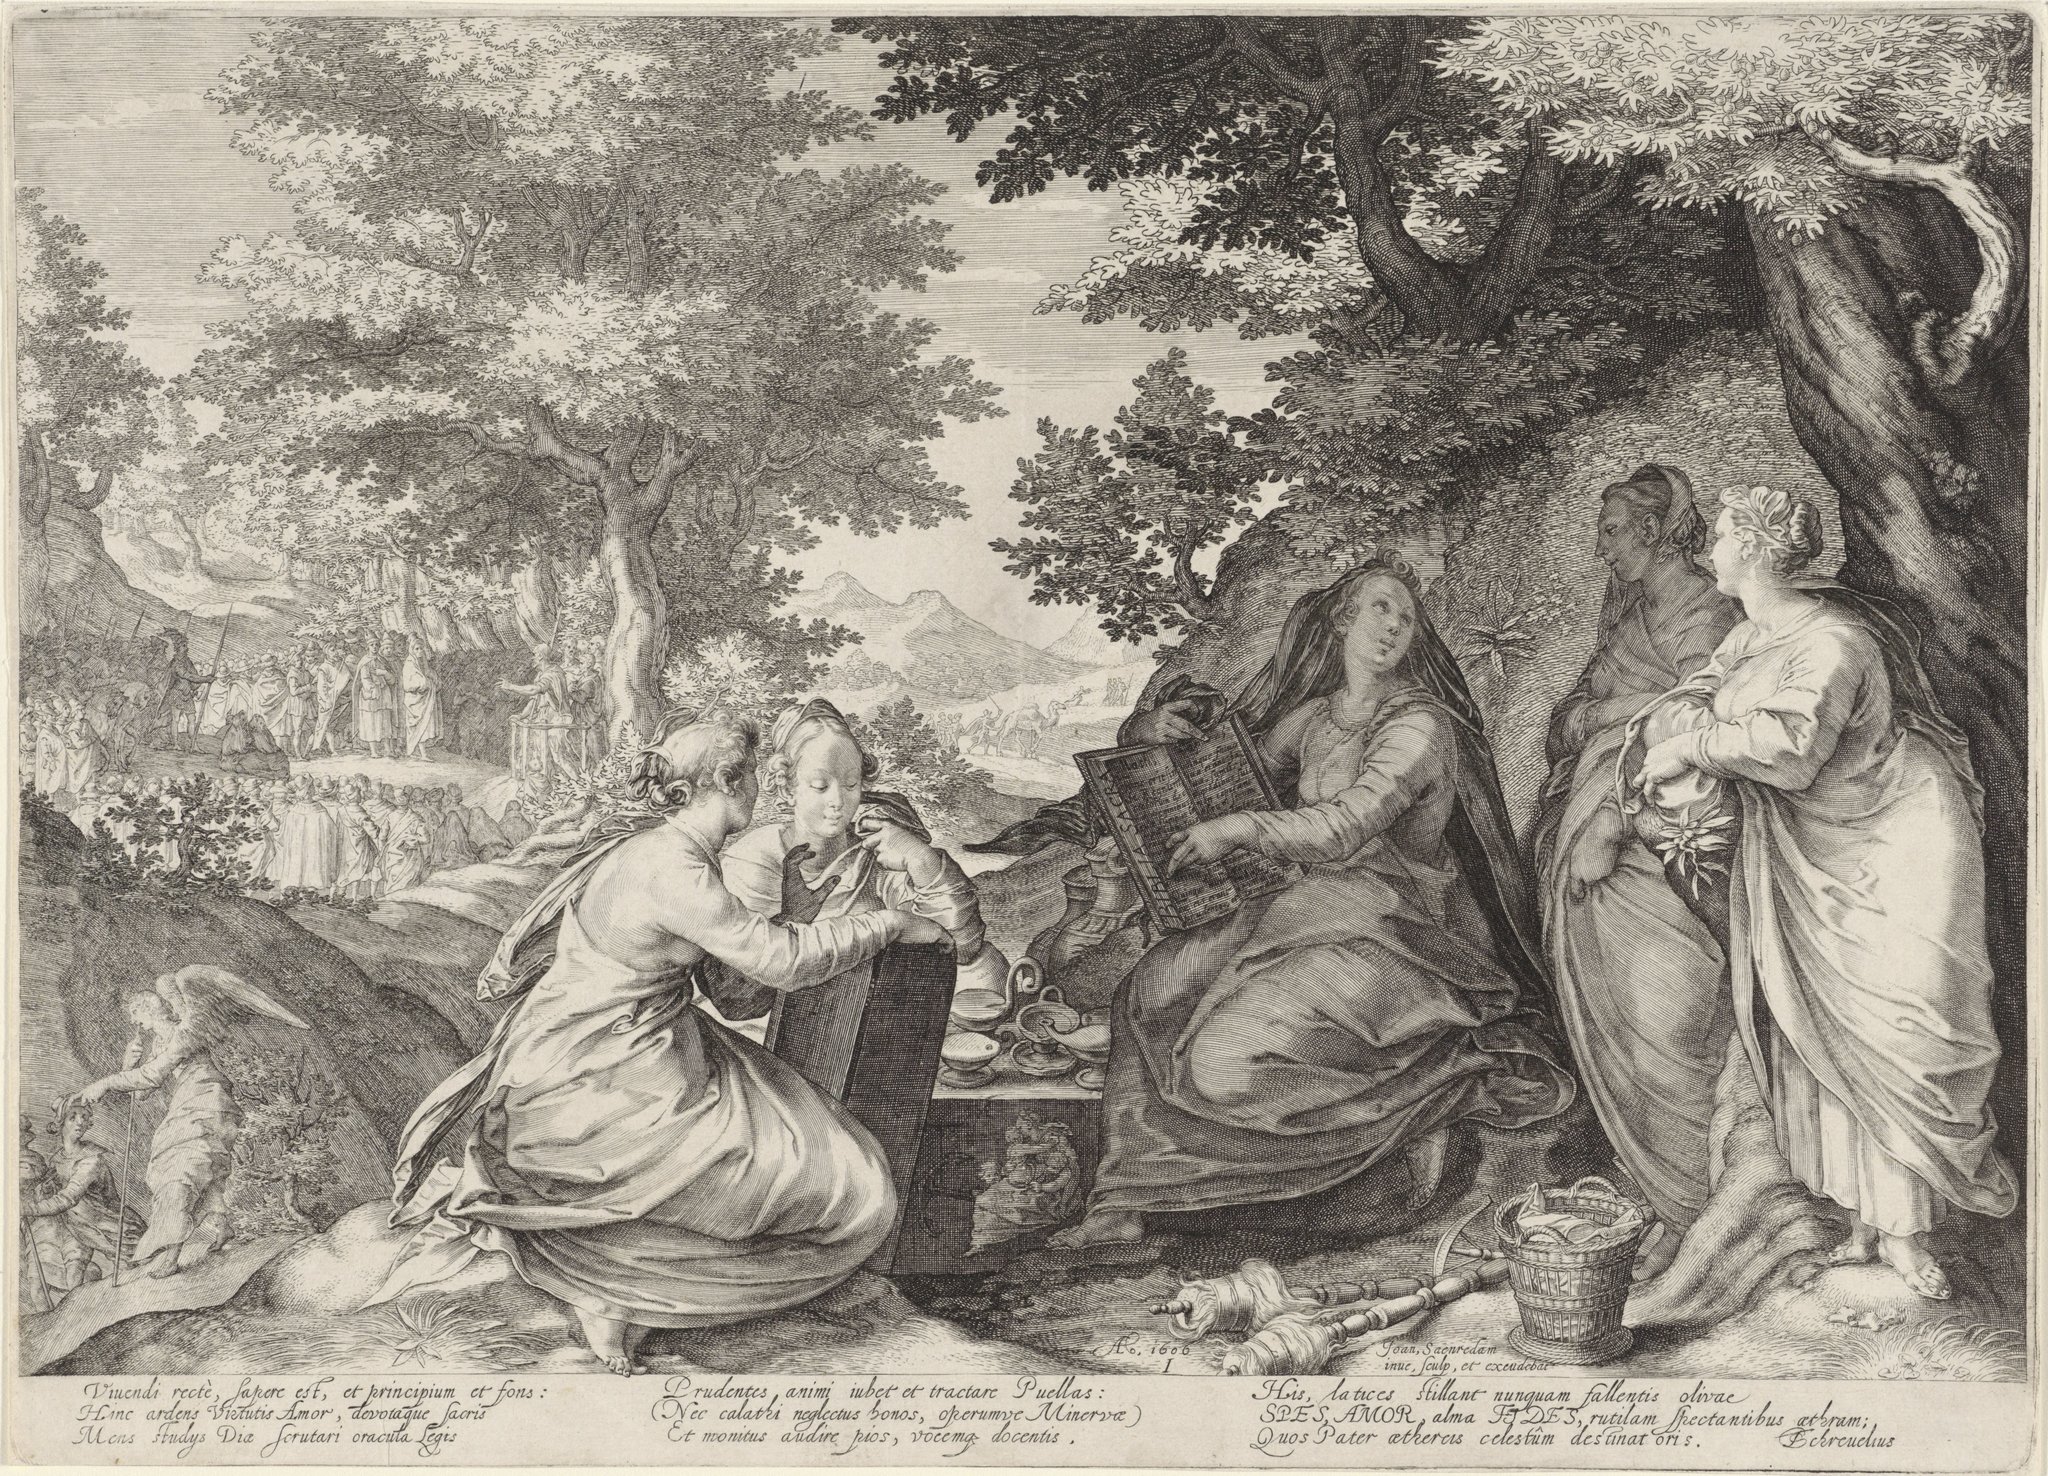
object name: print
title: Vijf wijze maagden in een landschap met de prediking door Johannes de Doper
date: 1606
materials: paper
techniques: engraving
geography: assendelft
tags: representation of wise virgin(s), forest, wood, john the baptist preaching (perhaps christ among the bystanders)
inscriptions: collector's mark: Lugt 240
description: Een boslandschap met op de voorgrond de vijf wijze maagden. Ze zitten rond een tafel met de olielampen en lezen uit de Bijbel en de tablet met de tien geboden. Naast hen kruiken met olie en voorwerpen van huiselijke vlijt. Links stuurt een engel twee reizigers weg. Op de achtergrond preekt Johannes de Doper op een open plek in het bos. De prent heeft een Latijns onderschrift.